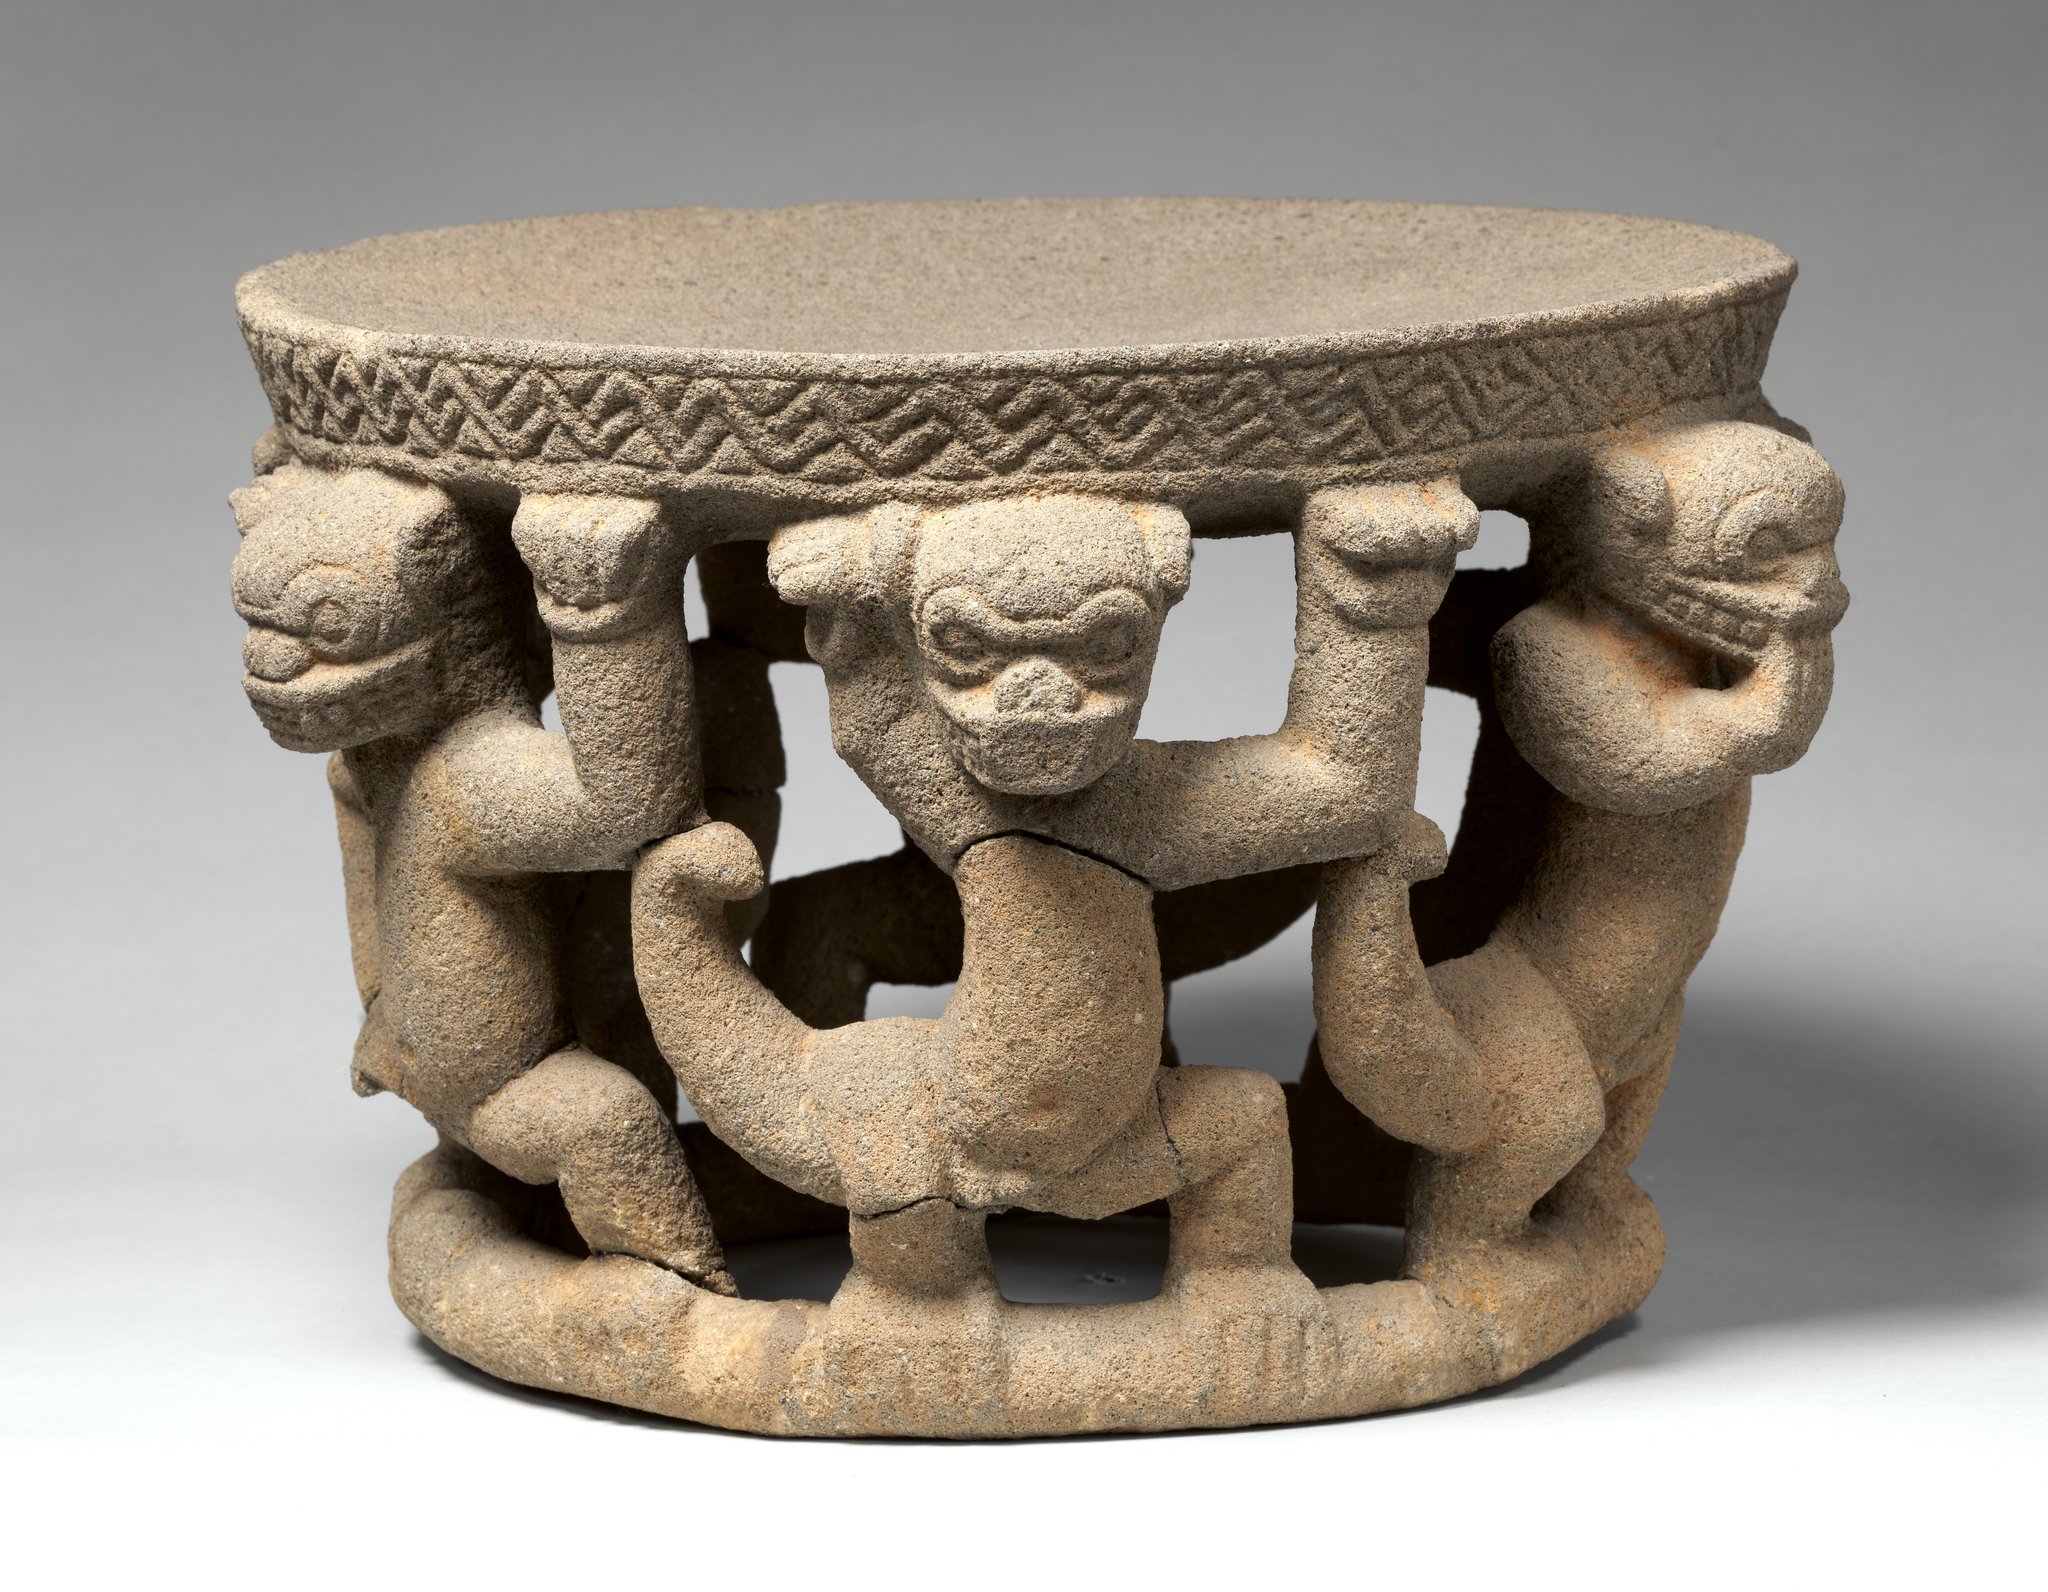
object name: metate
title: Ceremonial Metate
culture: atlantic watershed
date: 901-1100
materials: stone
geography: costa rica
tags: animals